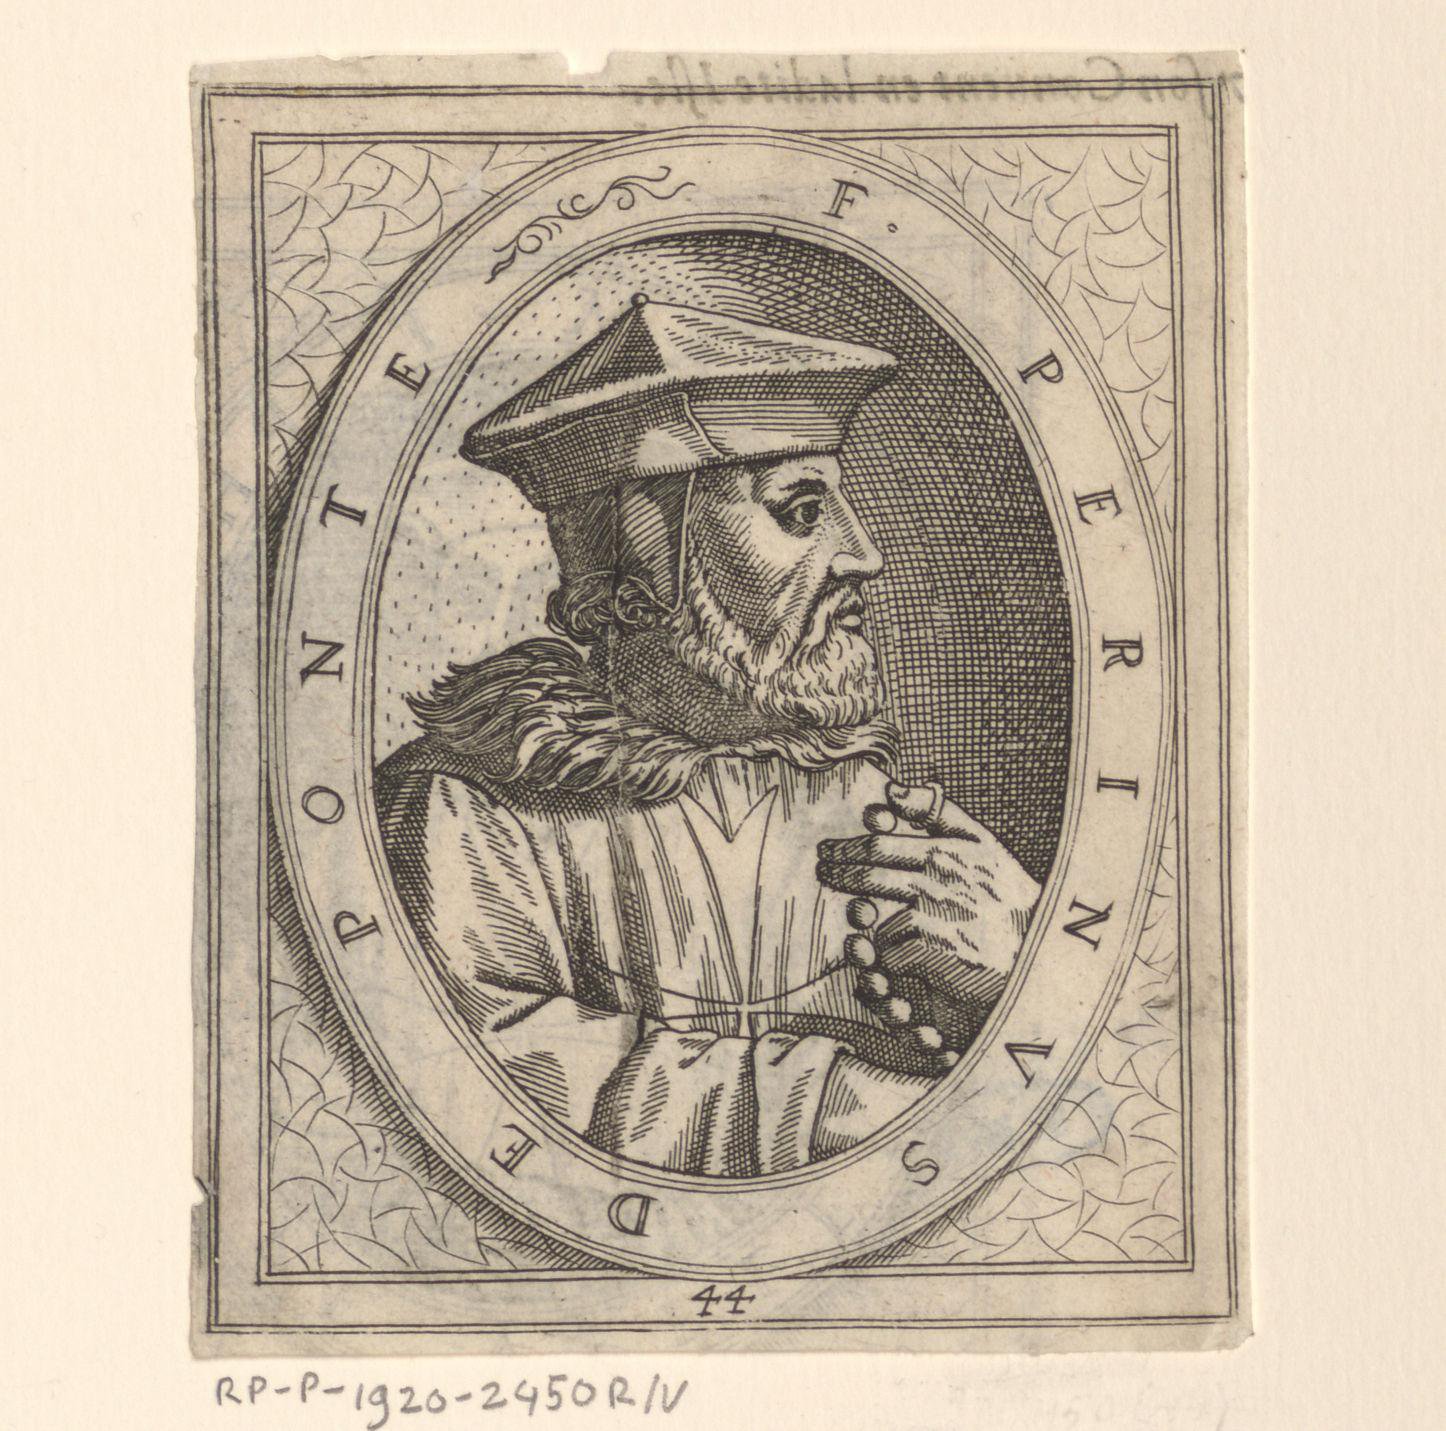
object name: print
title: Portret van Piero de Ponte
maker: Anonymous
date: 1643-1659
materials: paper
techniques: engraving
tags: historical persons, military orders, e.g.: knights templars, knights of malta, teutonic knights ~ roman catholic church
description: Prent mogelijk uit: Baudoin, Jean. Histoire des chevaliers de l'ordre de s. Jean de Hierusalem (...). Parijs: Jacques Dallin, 1643. Of uit: Baudoin, Jean. Histoire des chevaliers de l'ordre de s. Jean de Hierusalem (...). Parijs: Thomas Jolly, 1659.